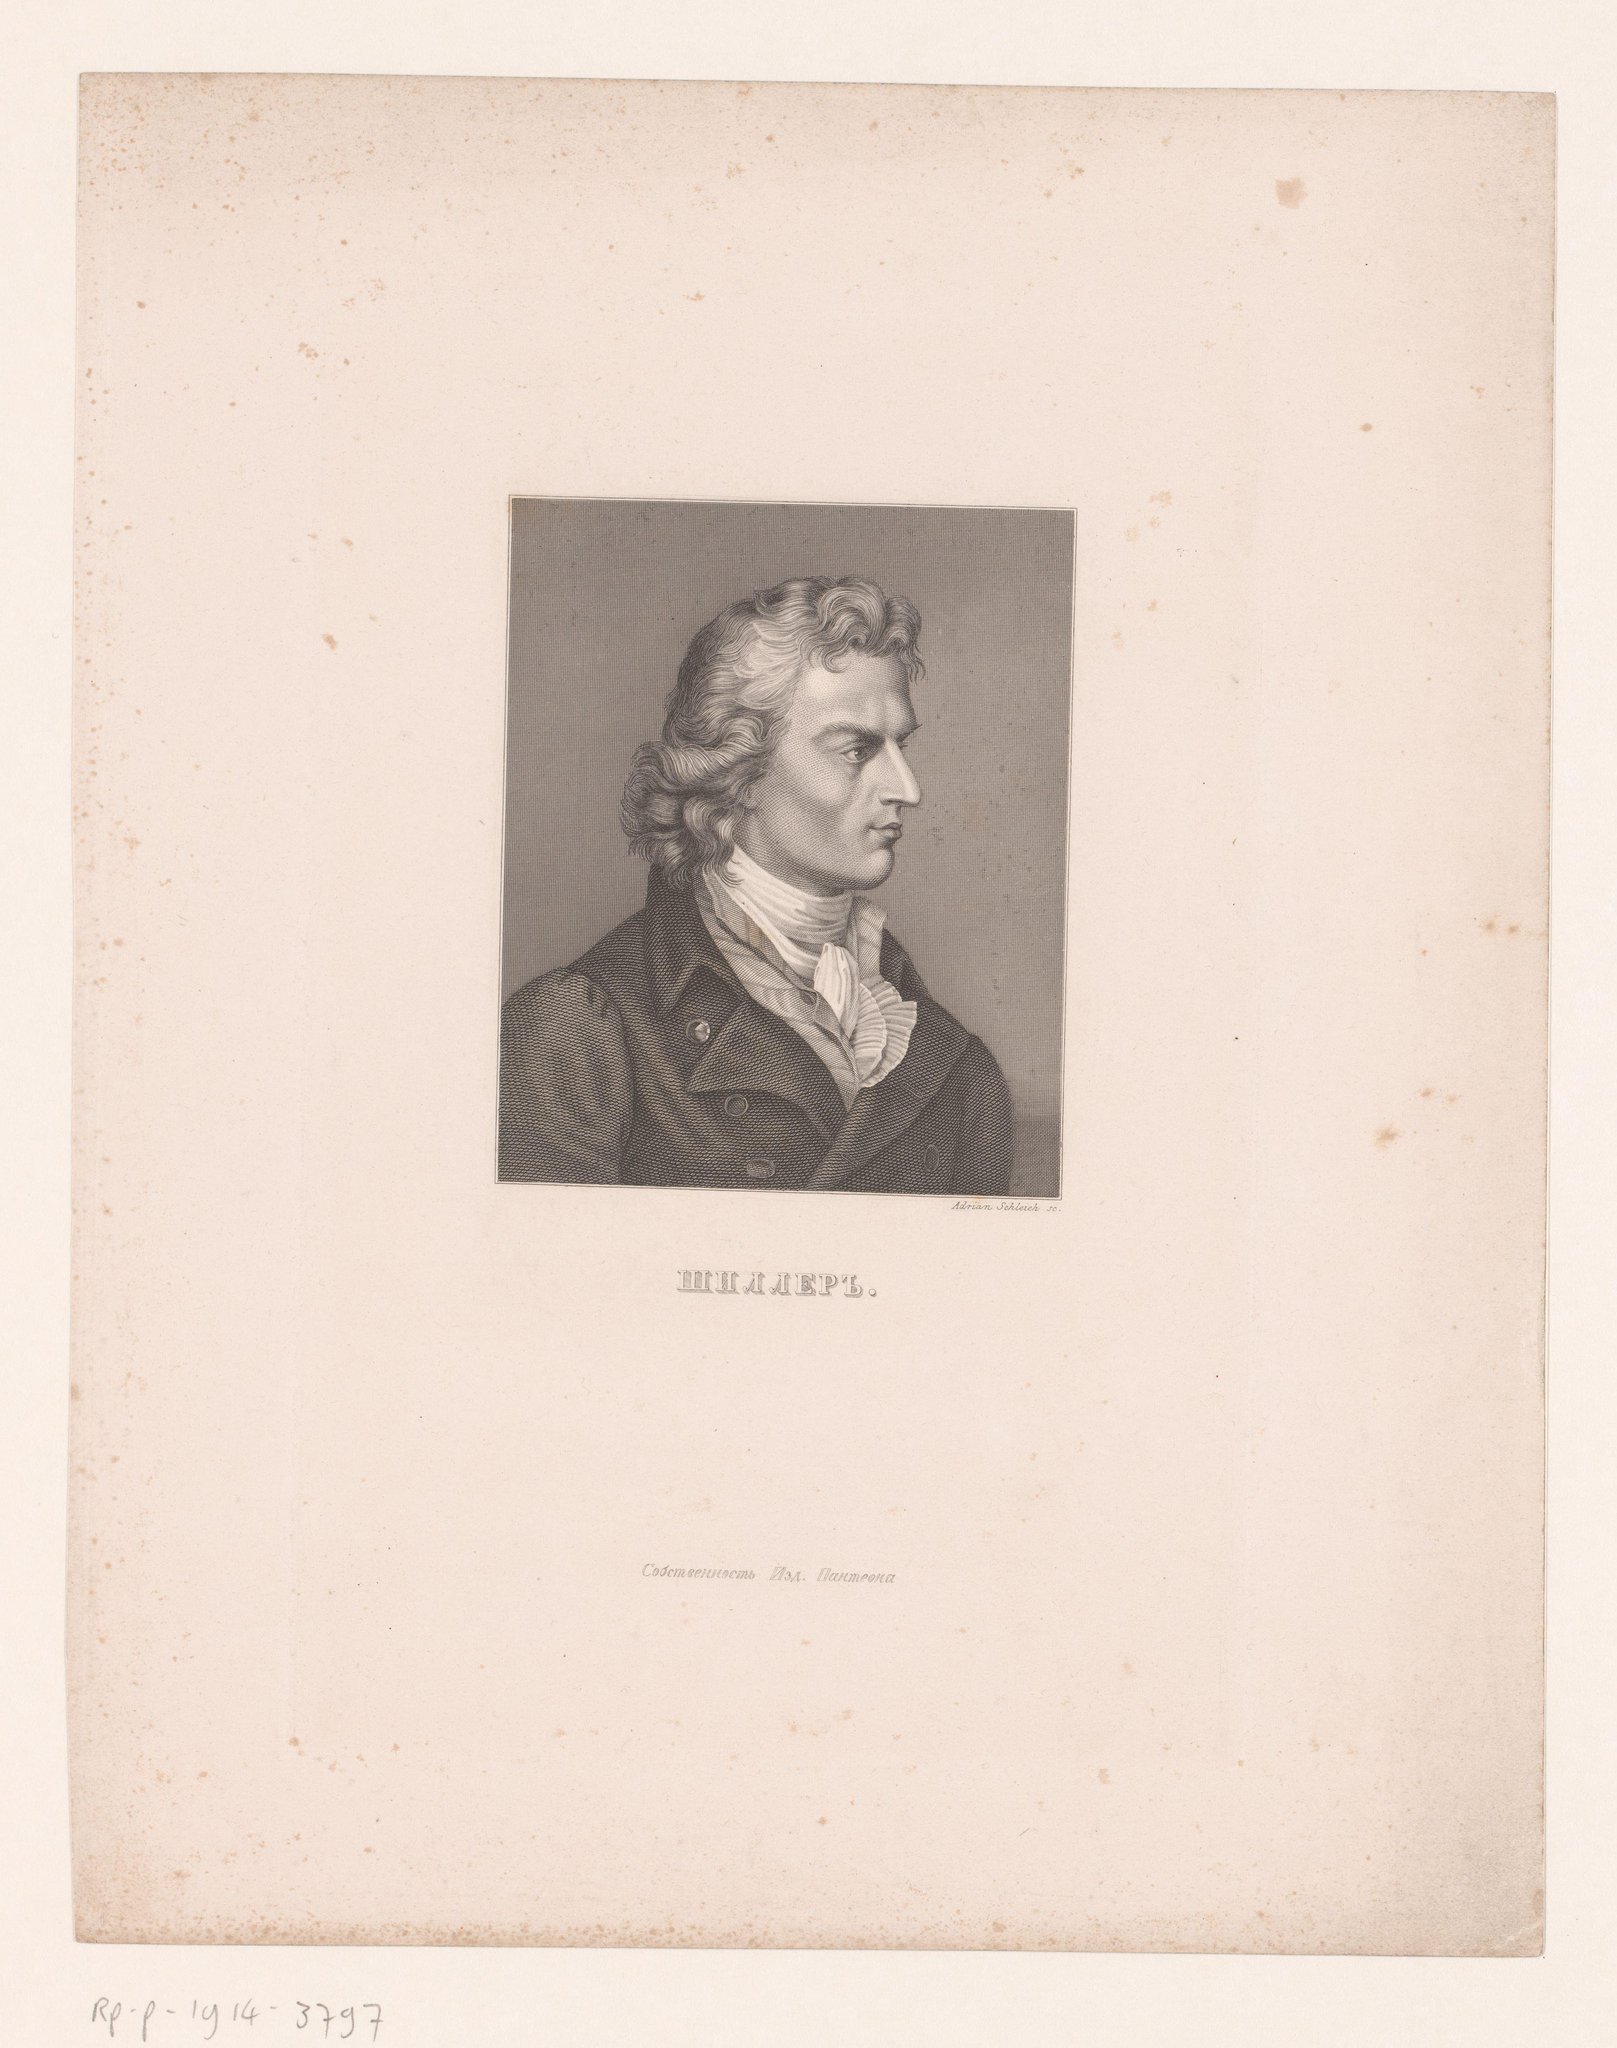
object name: print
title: Portret van Friedrich von Schiller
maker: adrian schleich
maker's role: print maker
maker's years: 1812-1894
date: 1822-1894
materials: paper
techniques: engraving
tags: friedrich von schiller, historical persons, portrait of a writer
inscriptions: collector's mark: Lugt 2228